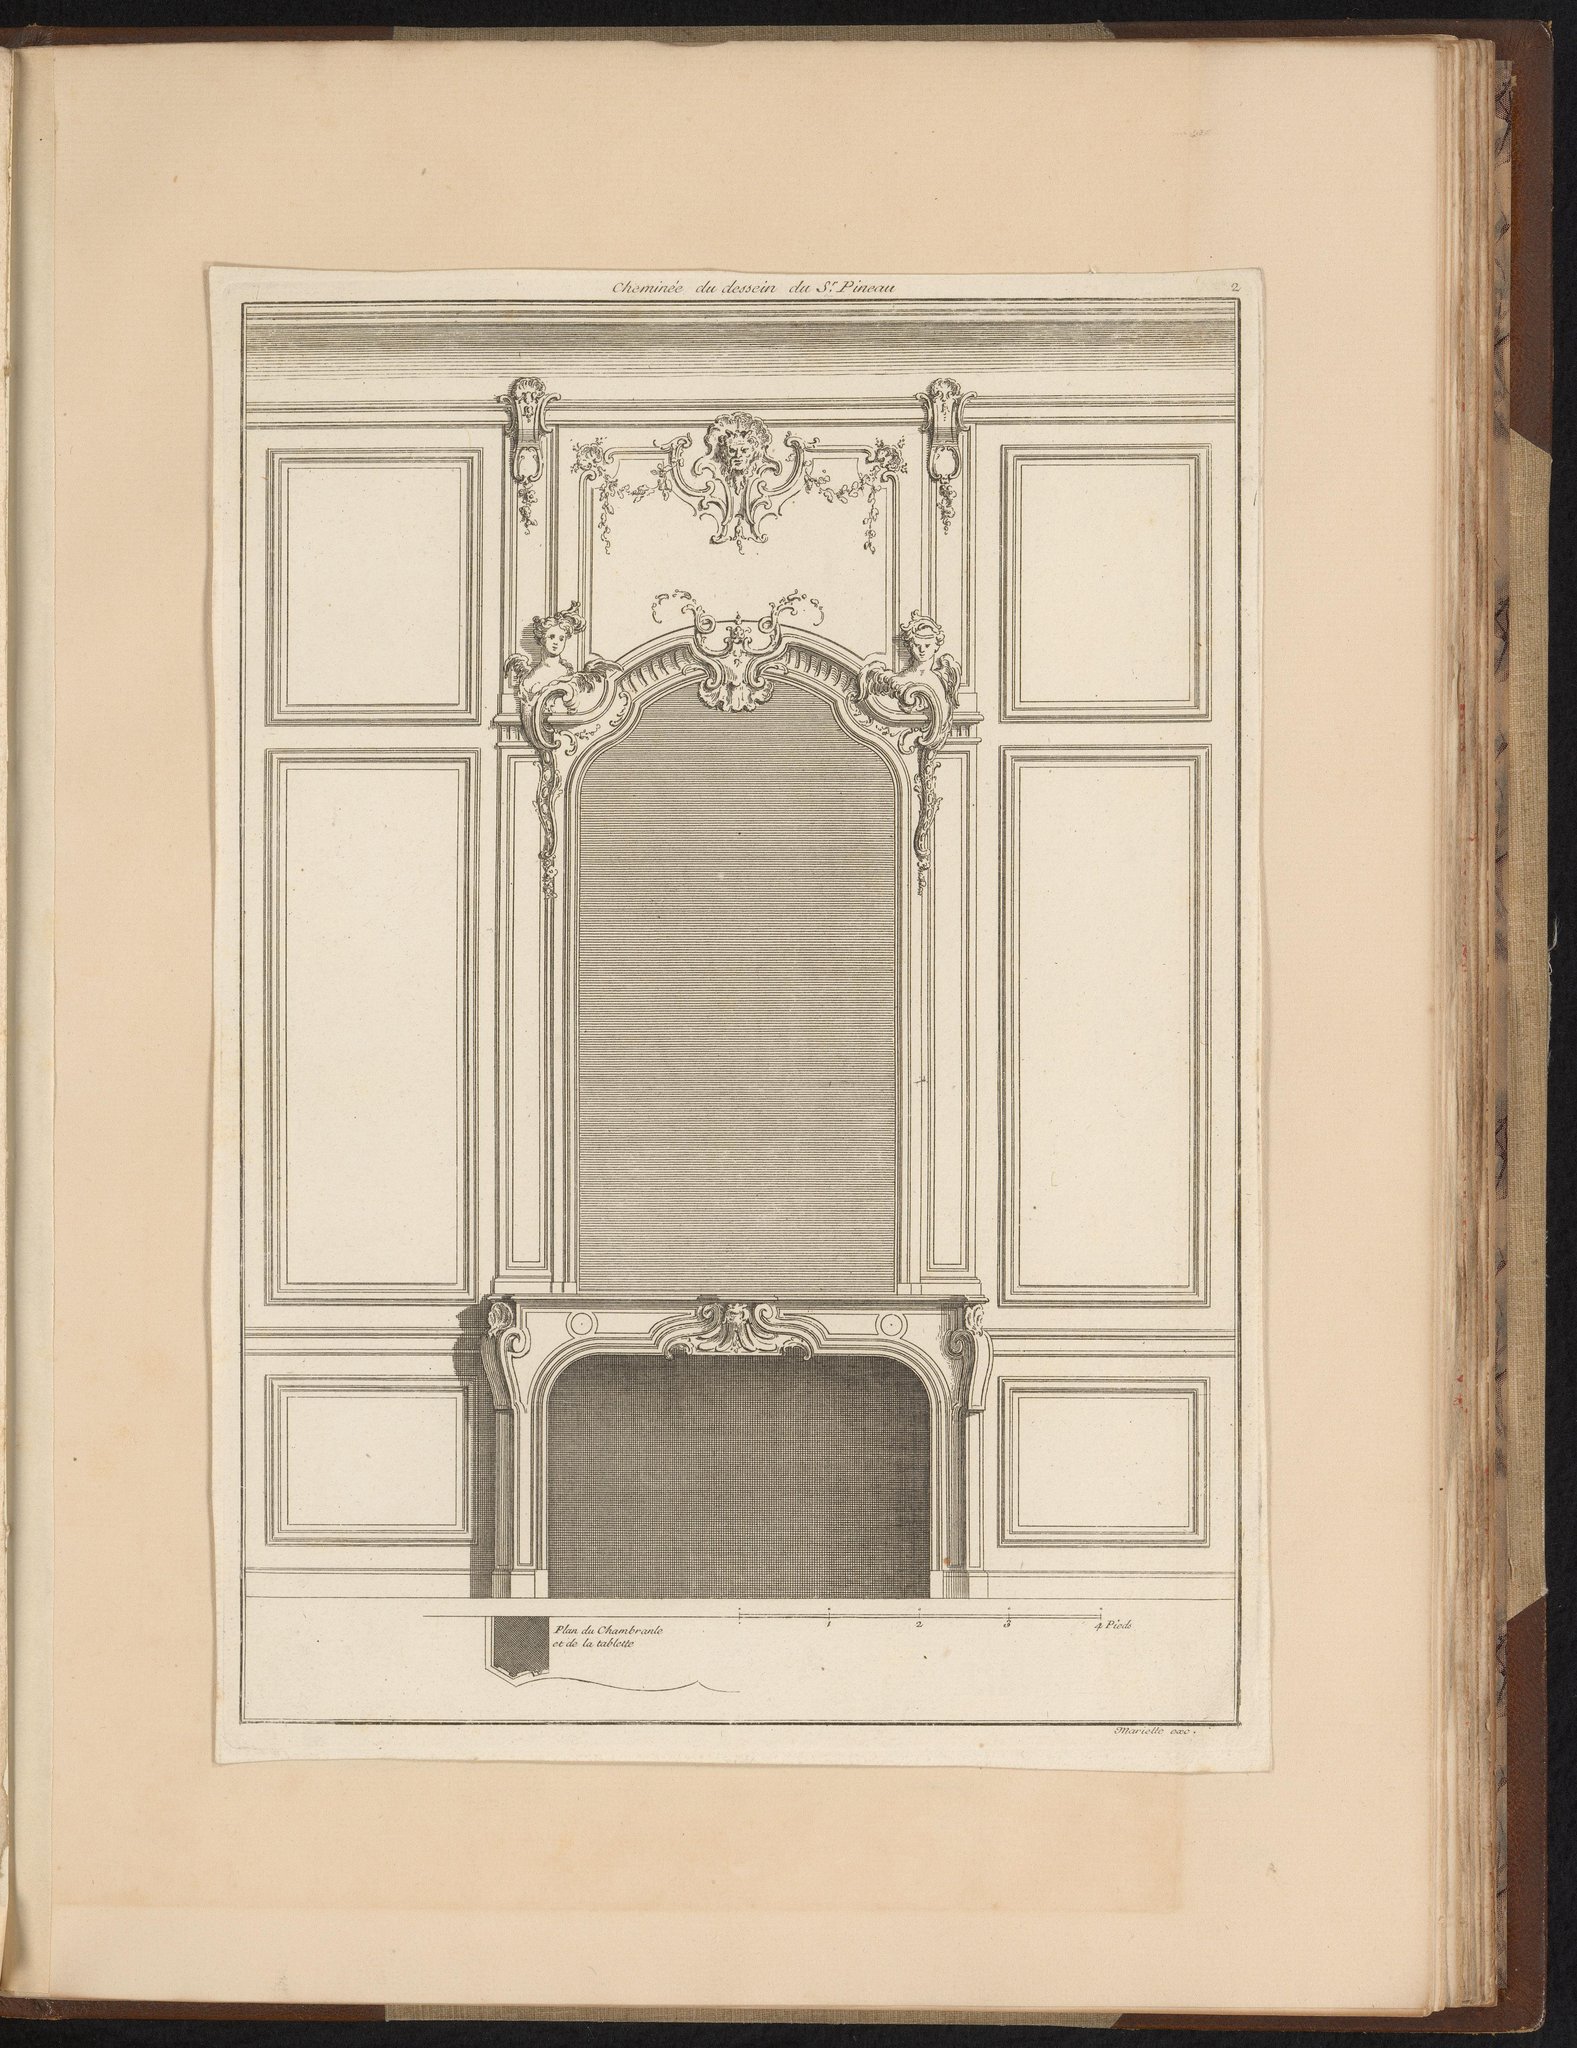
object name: print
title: Ontwerpen van beschot en schouwen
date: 1725-1750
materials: paper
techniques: etching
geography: paris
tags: chimney, ornaments ~ art, panelling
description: Deze prent maakt deel uit van een album.